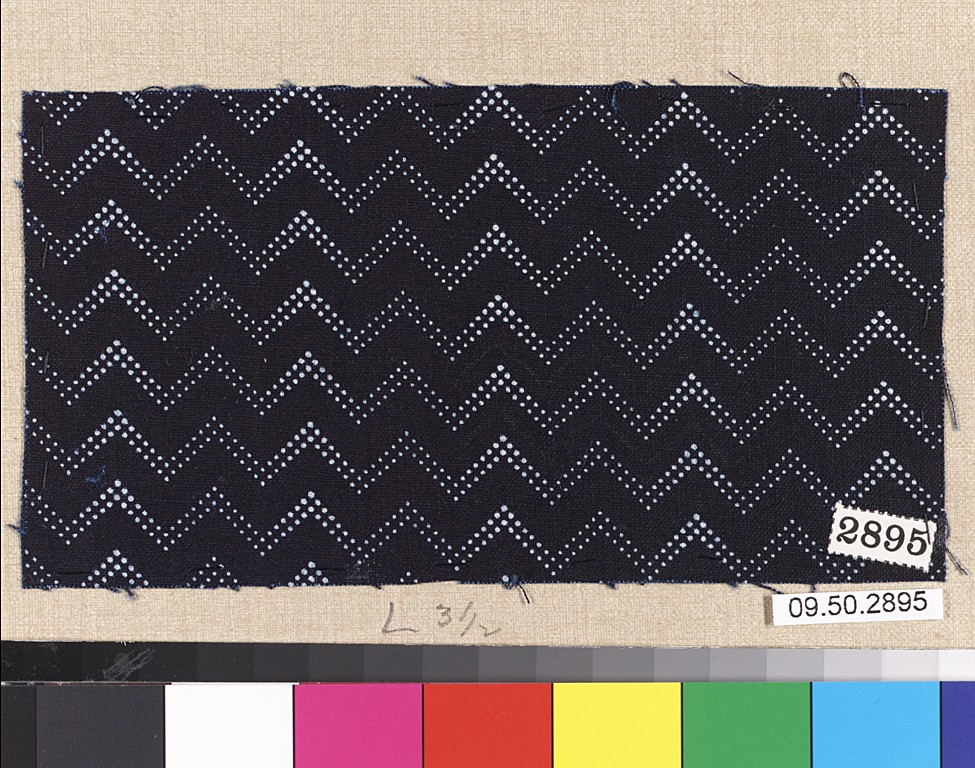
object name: piece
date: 1801-1900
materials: cotton